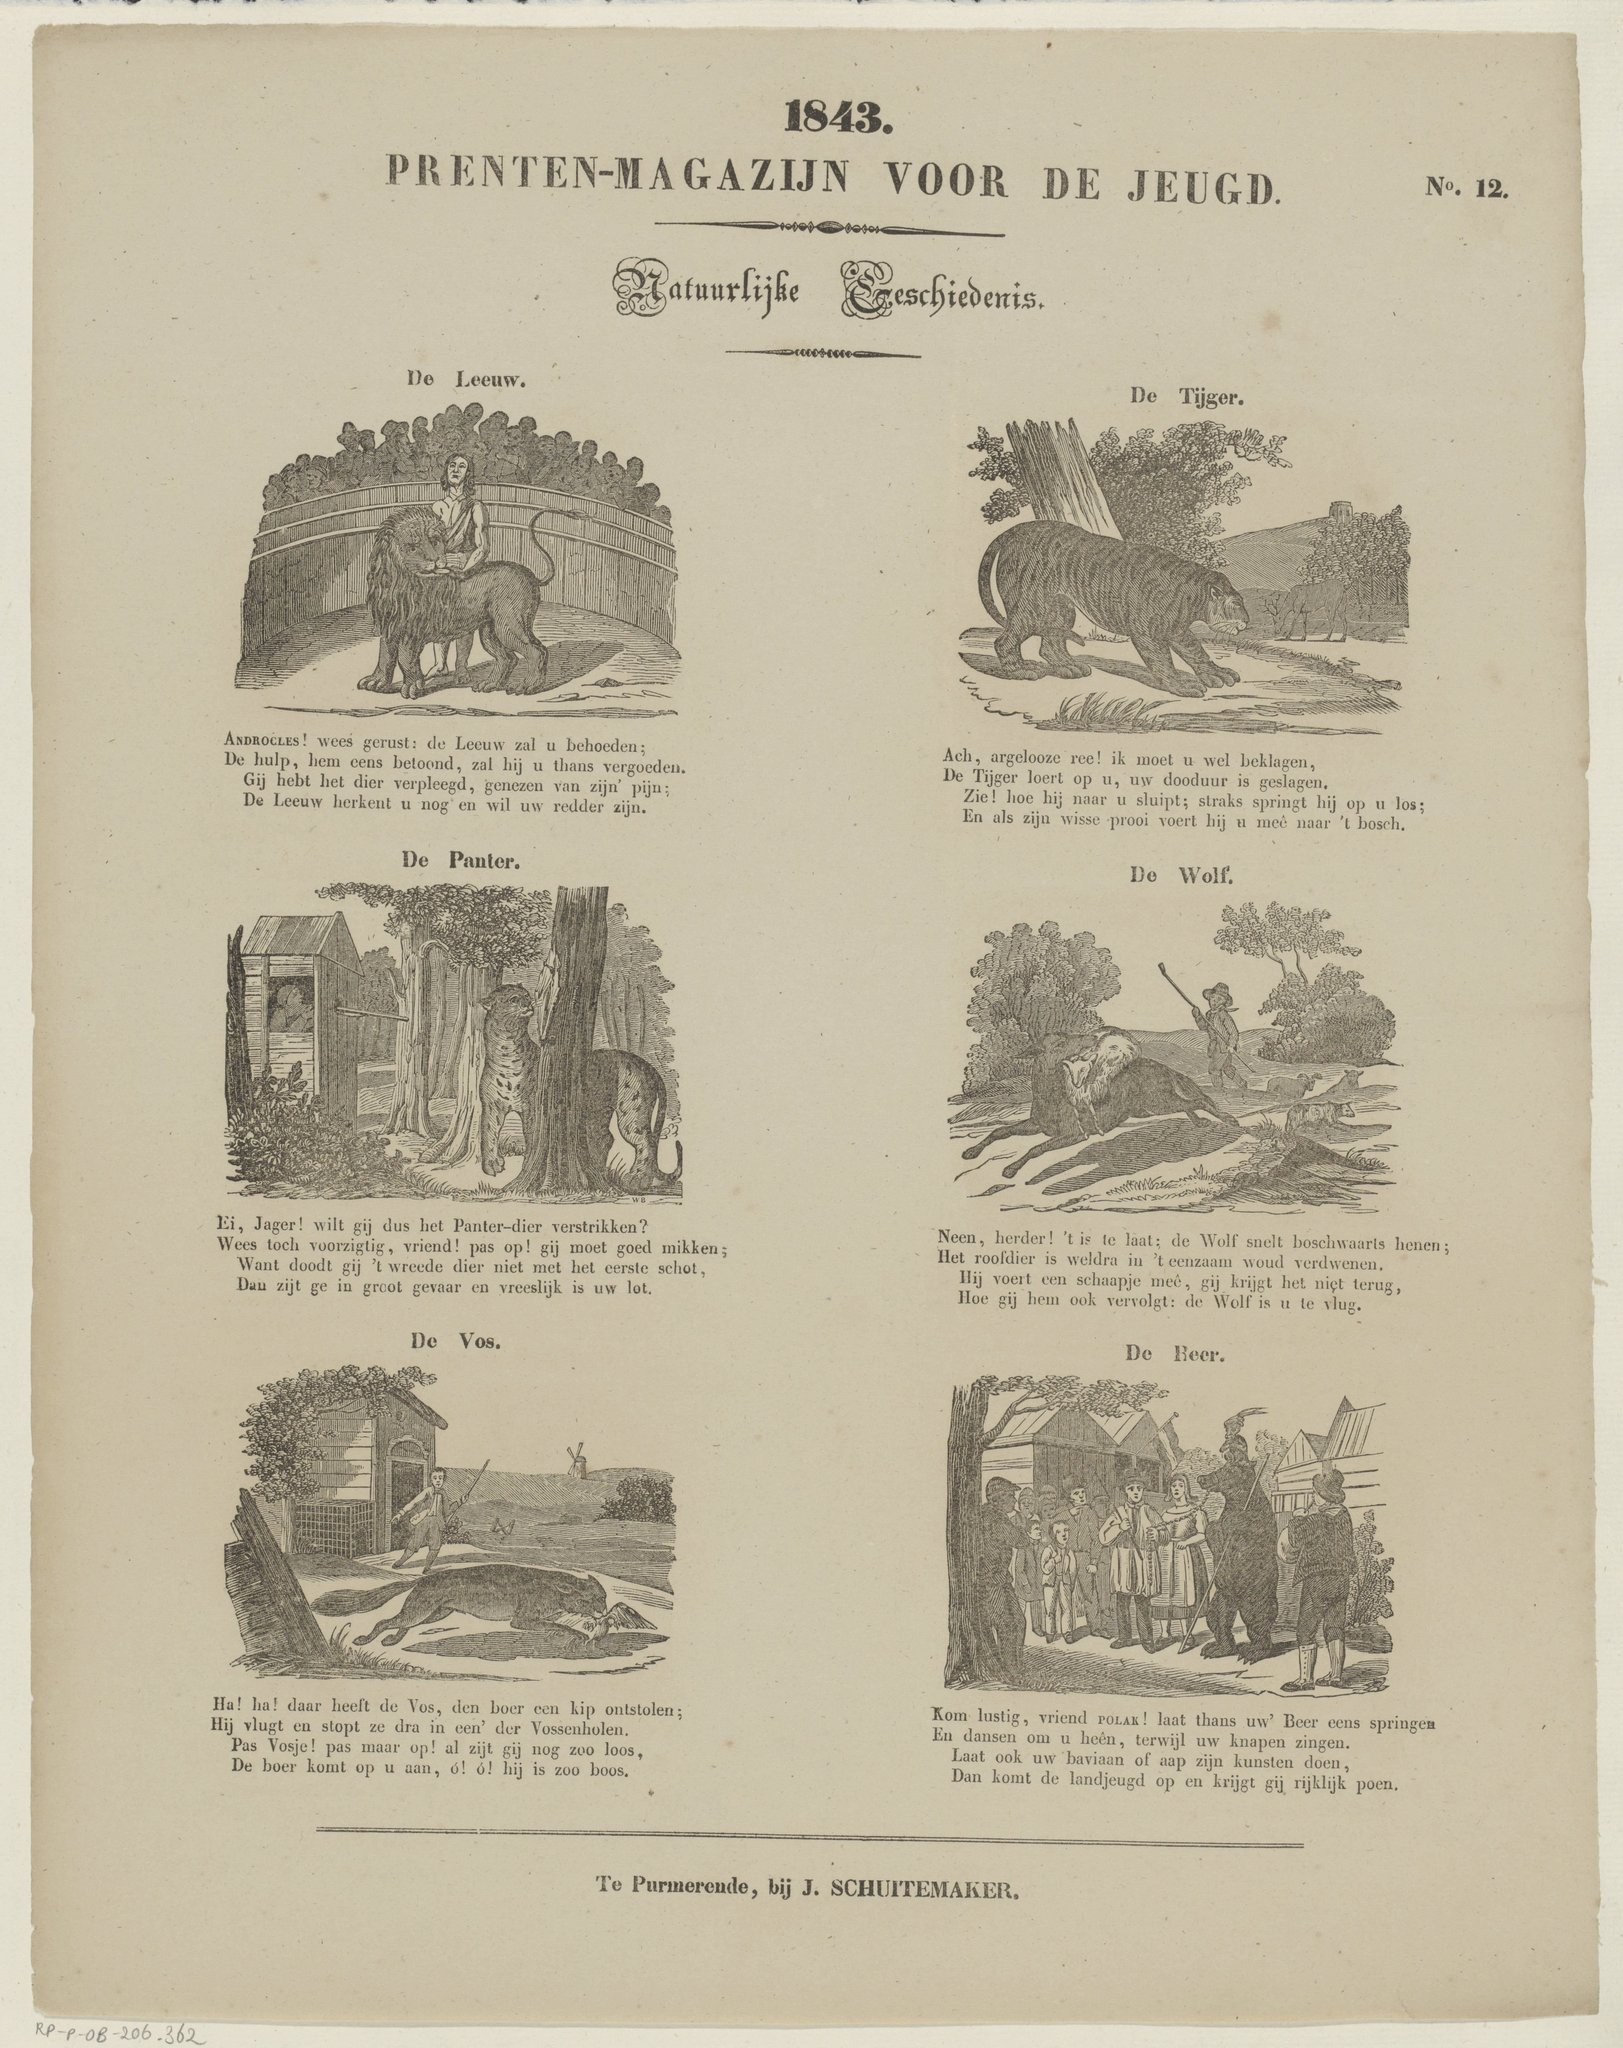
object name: print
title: Natuurlijke geschiedenis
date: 1843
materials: paper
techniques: letterpress printing, engraving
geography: purmerend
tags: beasts of prey, predatory animals: tiger, animals, beasts of prey, predatory animals: panther, beasts of prey, predatory animals: bear, beasts of prey, predatory animals: lion, beasts of prey, predatory animals: fox, beasts of prey, predatory animals: wolf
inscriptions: collector's mark: Lugt 2760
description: Blad met 6 voorstellingen van verschillende dieren: een leeuw, een tijger, een panter, een wolf, een vos en een beer. Boven elke voorstelling een titel en onder elke voorstelling een vierregelig vers. Genummerd rechtsboven: No. 12.